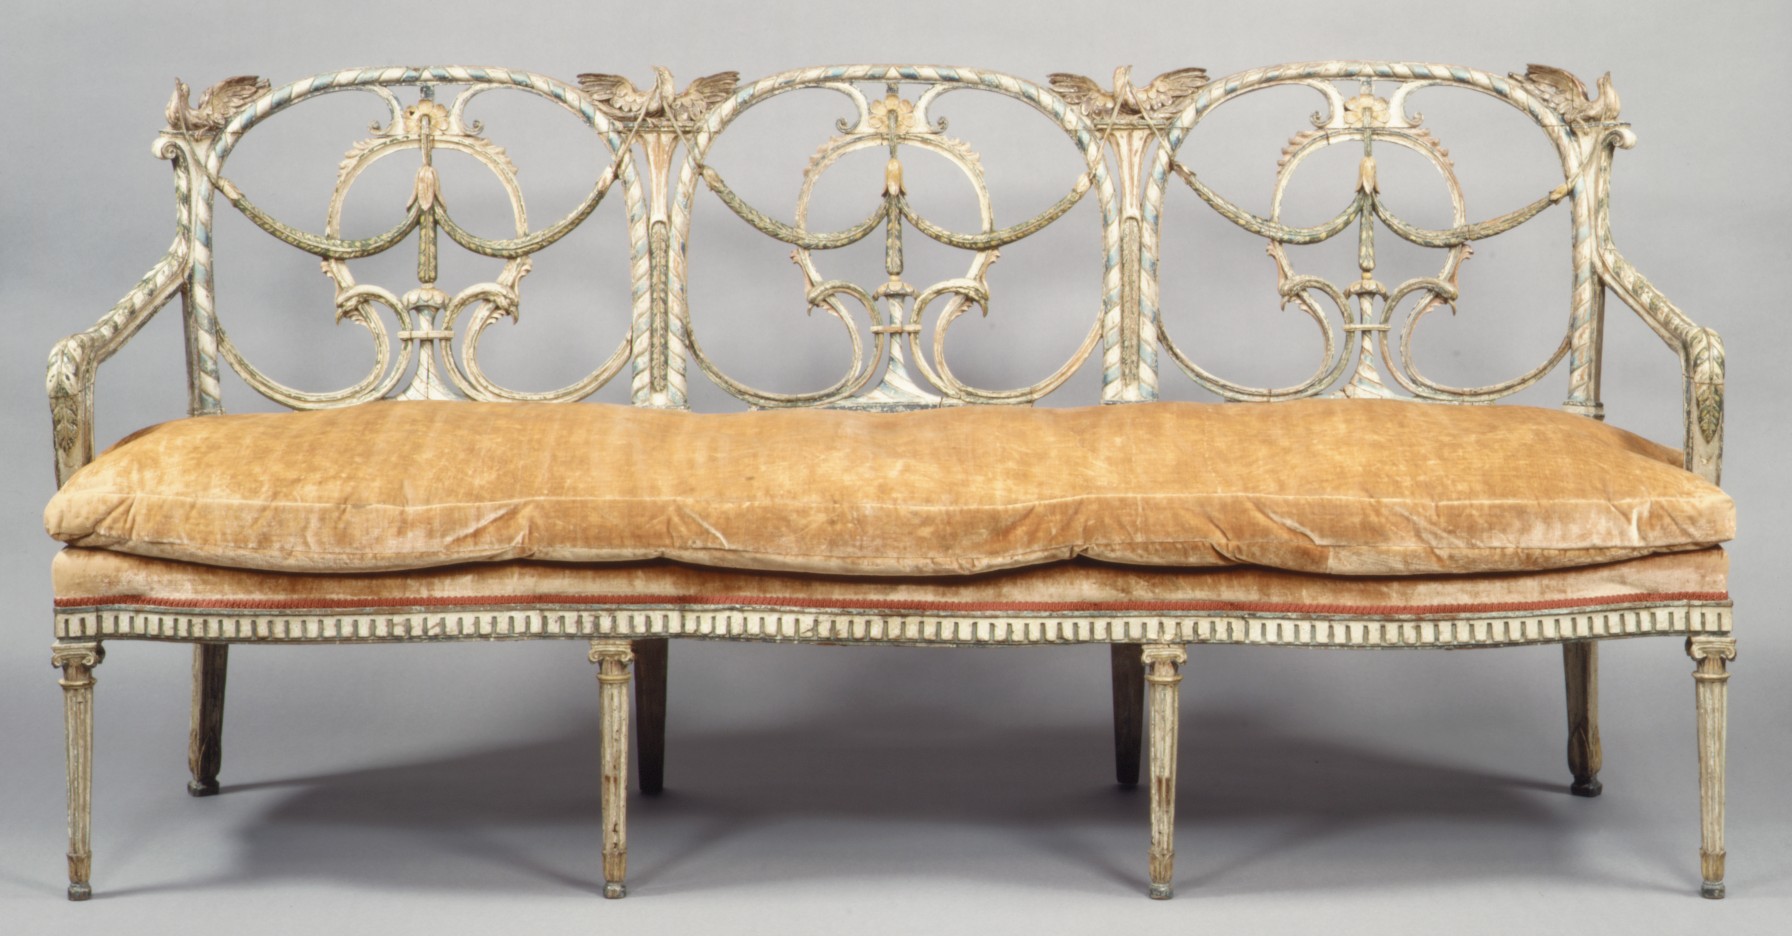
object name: settee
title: Settee (part of a set)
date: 1760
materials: velvet, wood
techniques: polychrome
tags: birds,furniture